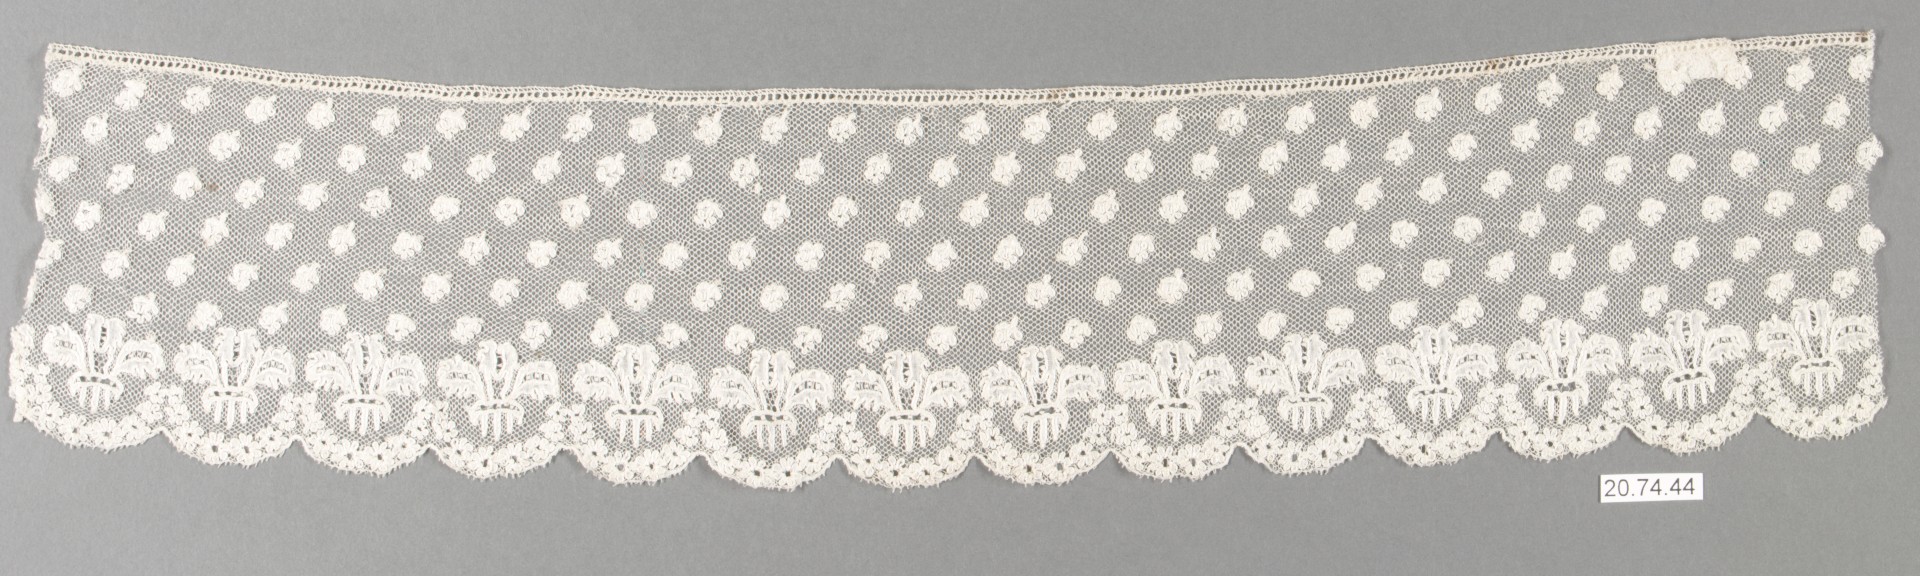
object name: fragment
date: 1801-1833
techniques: lace